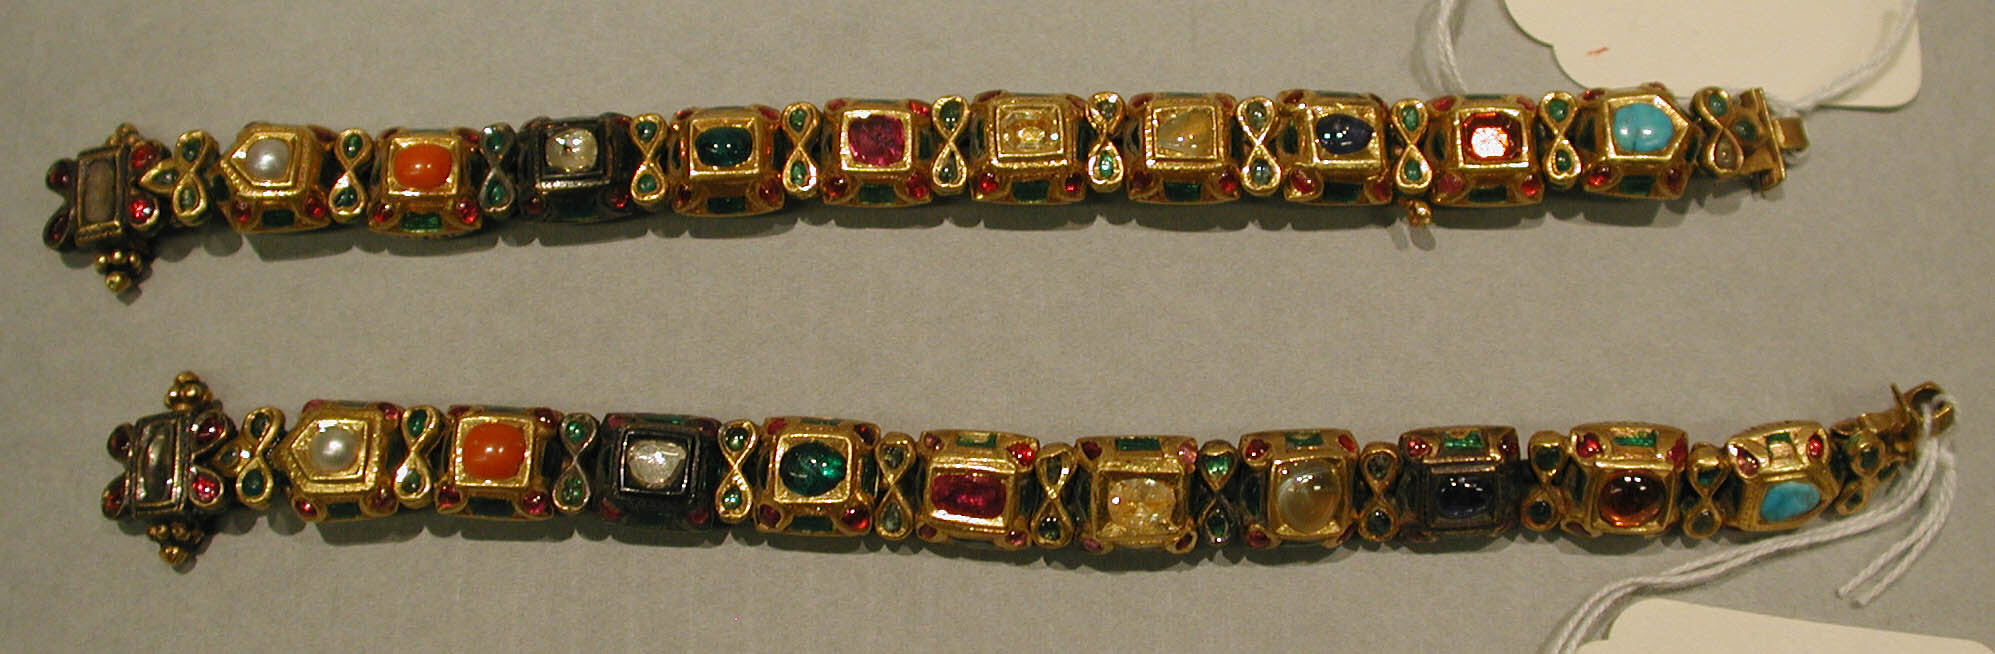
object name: bracelet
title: Nine-Gem (Navaratna) Talismanic Bracelet, One of a Pair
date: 1801-1900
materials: stone, coral, diamond, gemstone, enamel, garnet, gold, pearl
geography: northern india